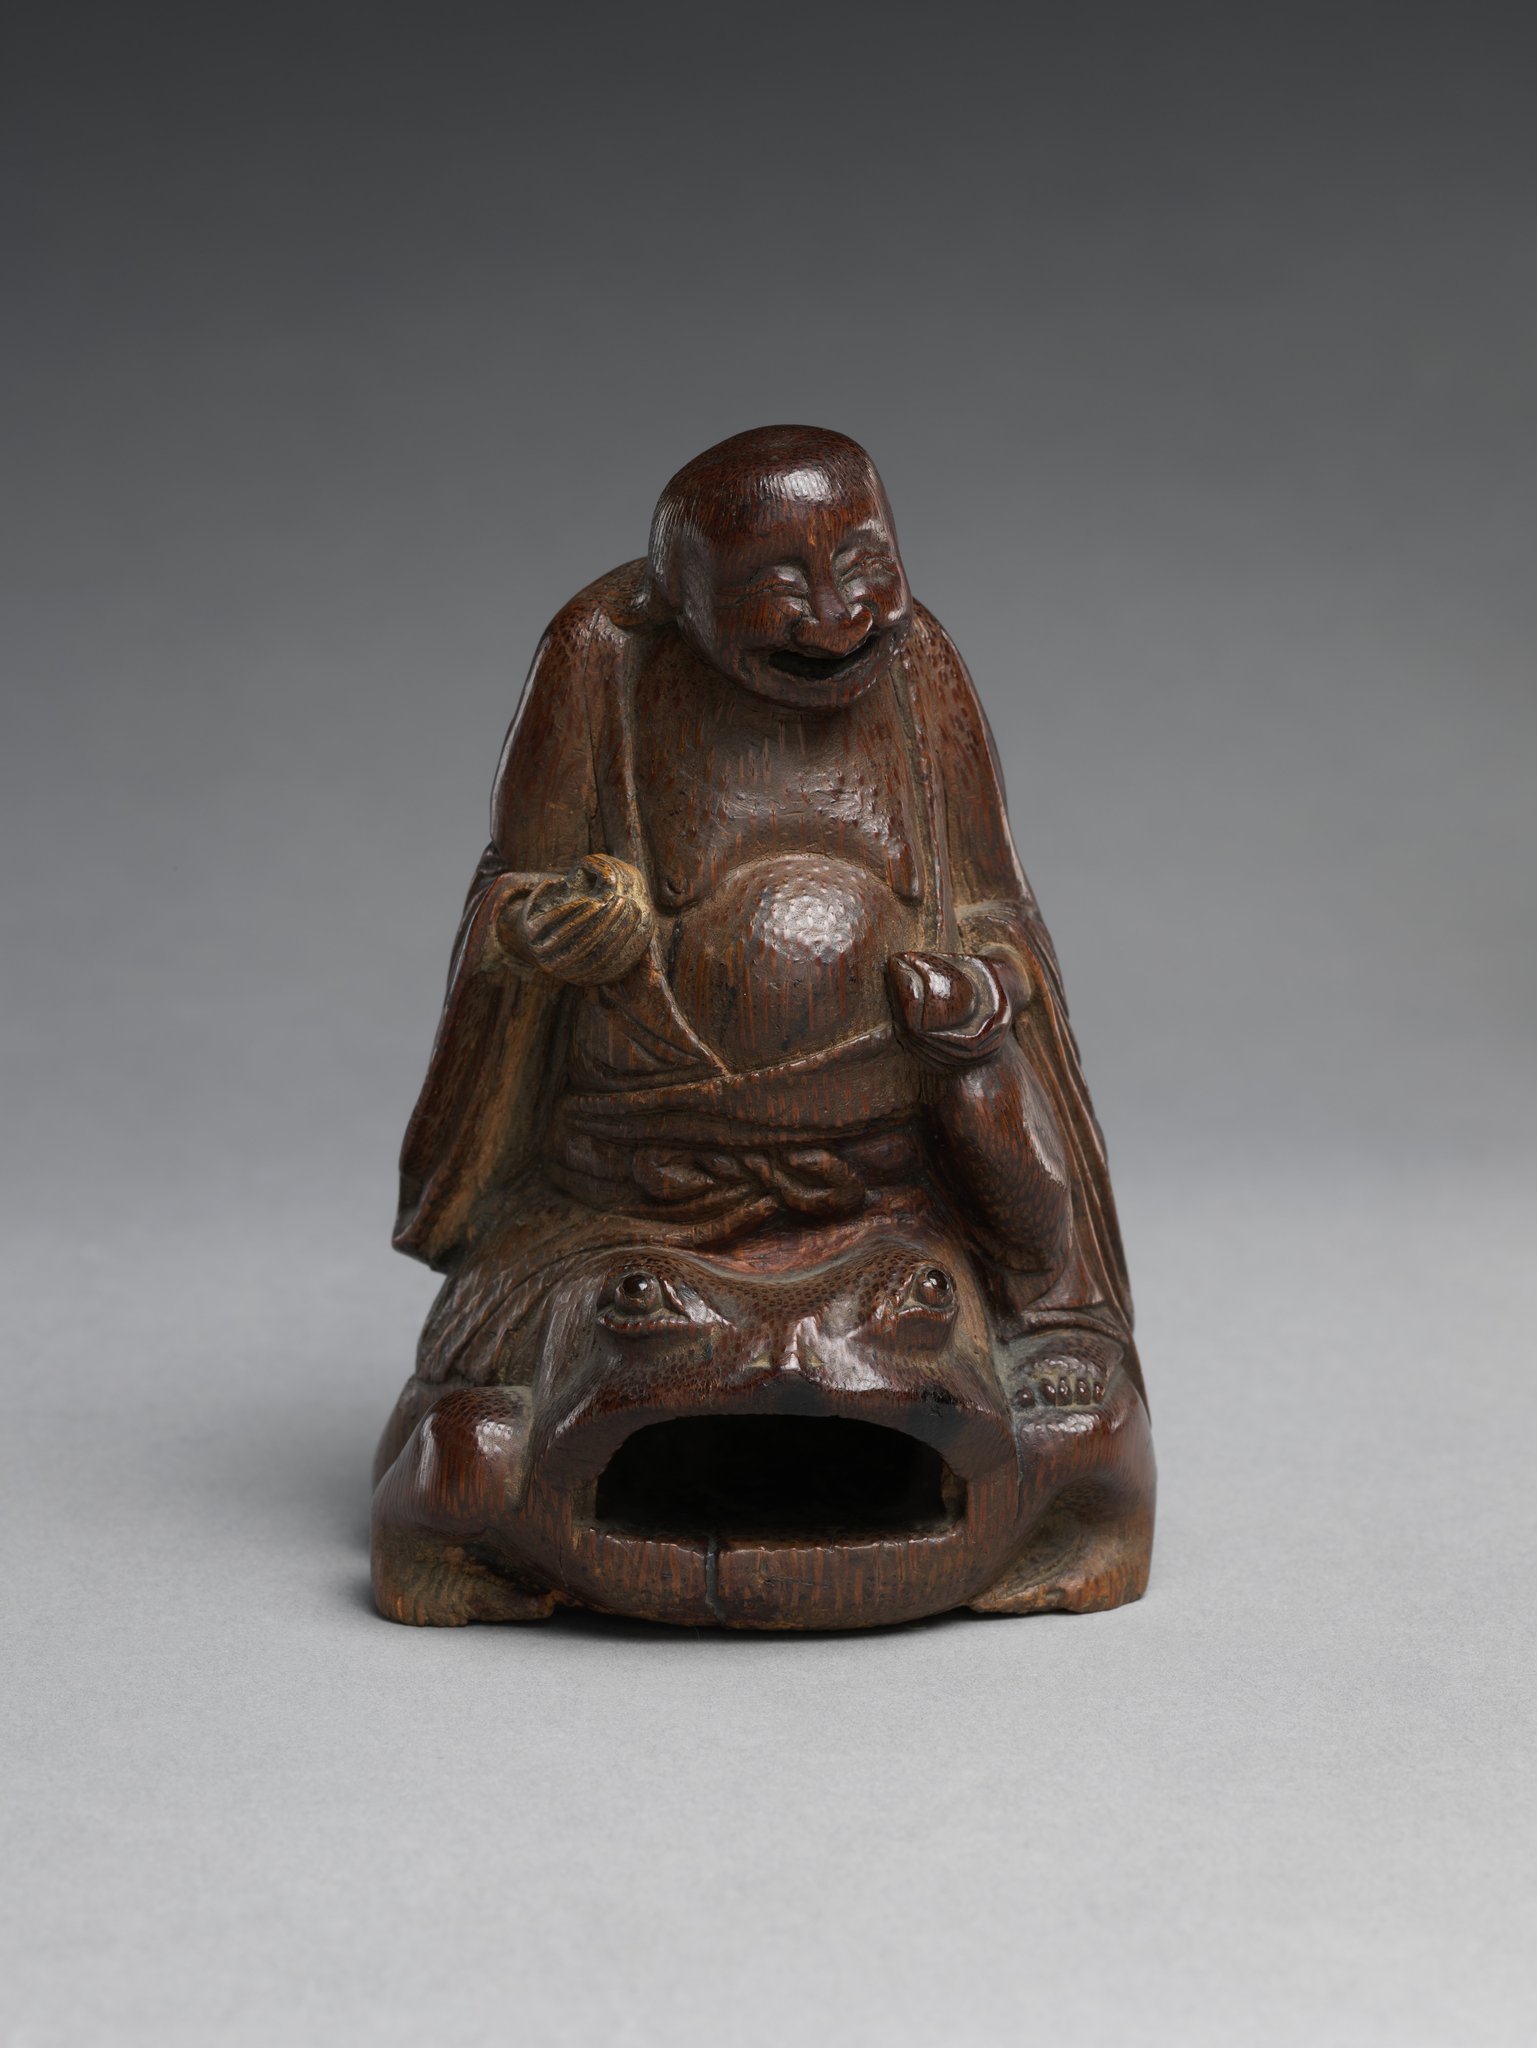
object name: figure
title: Immortal Liu Hai astride a toad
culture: chinese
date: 1701-1900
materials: bamboo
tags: men